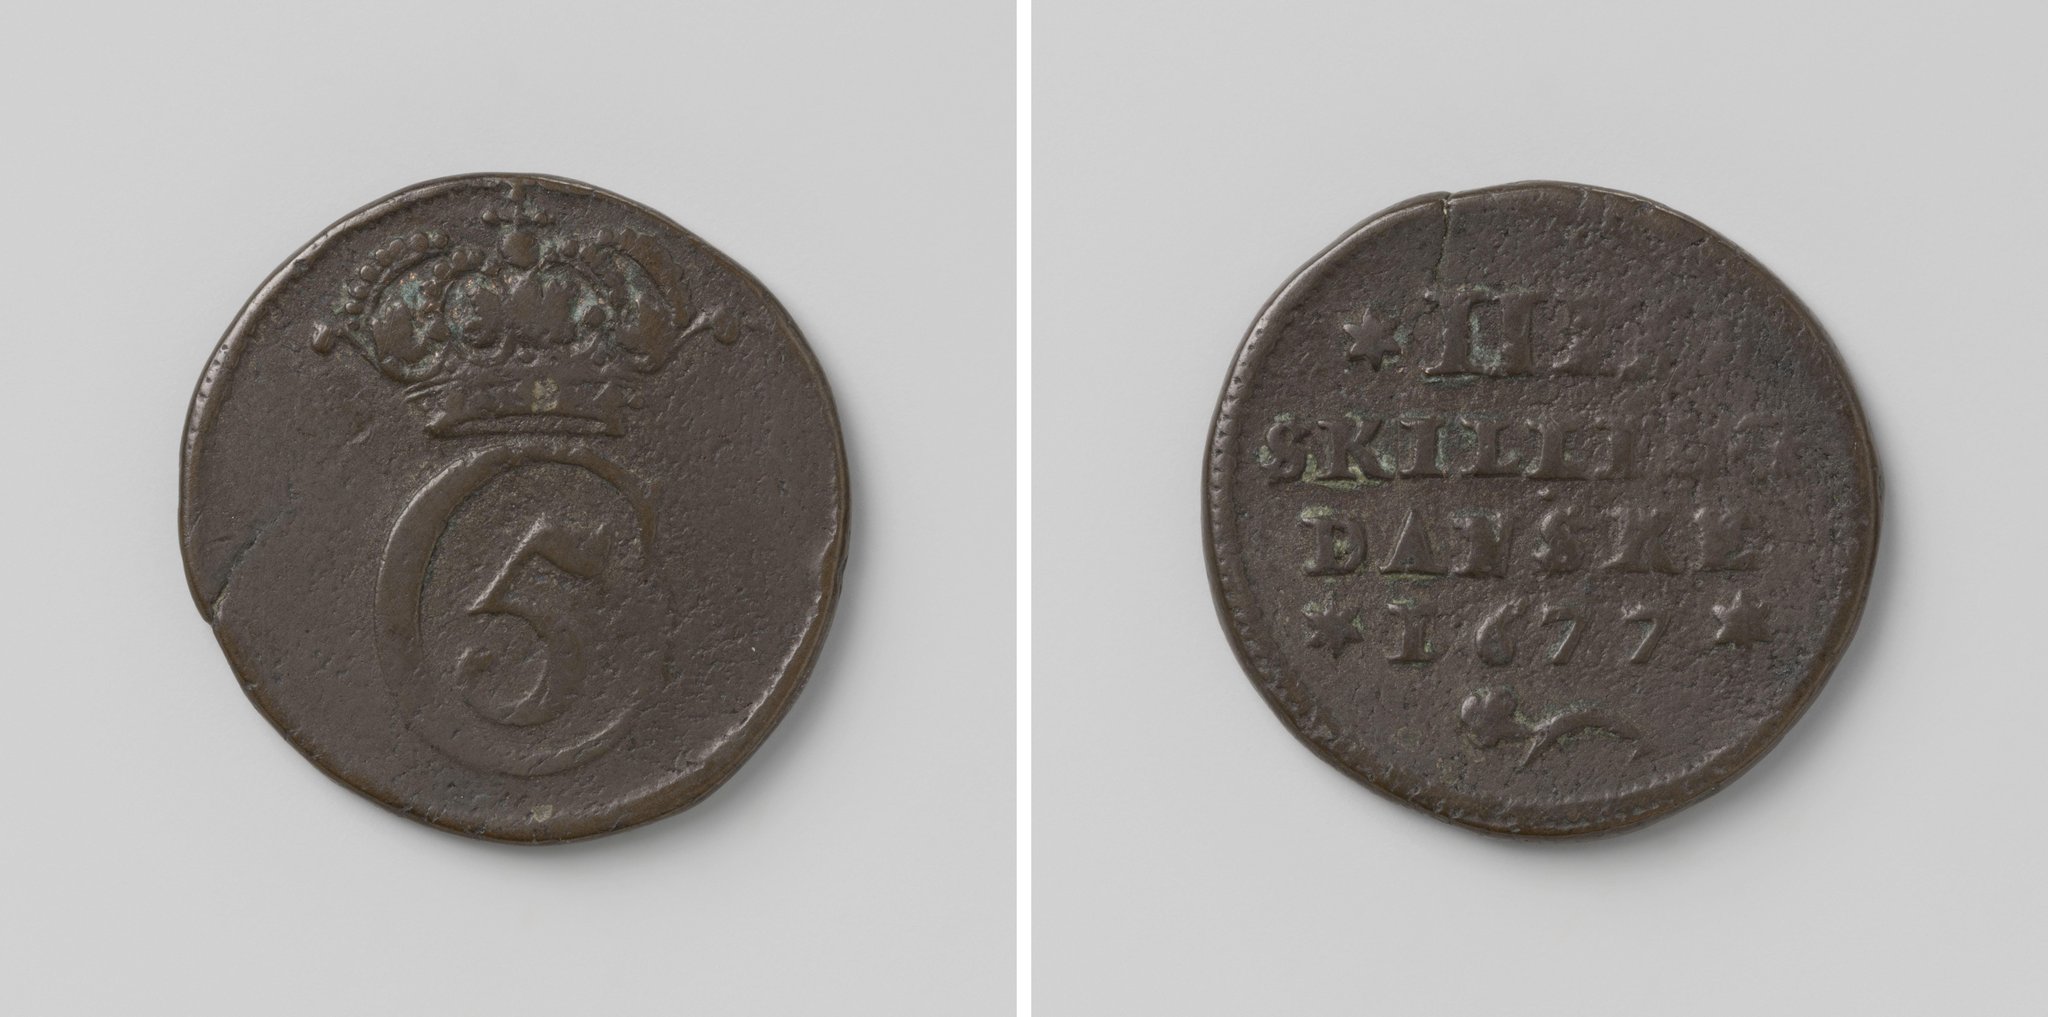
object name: siege coin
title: Vier skilling, noodmunt van Christiaan V, koning van Denemarken, geslagen tijdens de oorlog met Zweden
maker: Anonymous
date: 1677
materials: copper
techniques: striking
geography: denmark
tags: copenhagen (city)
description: Voorzijde: gekroond monogram. Keerzijde: opschrift